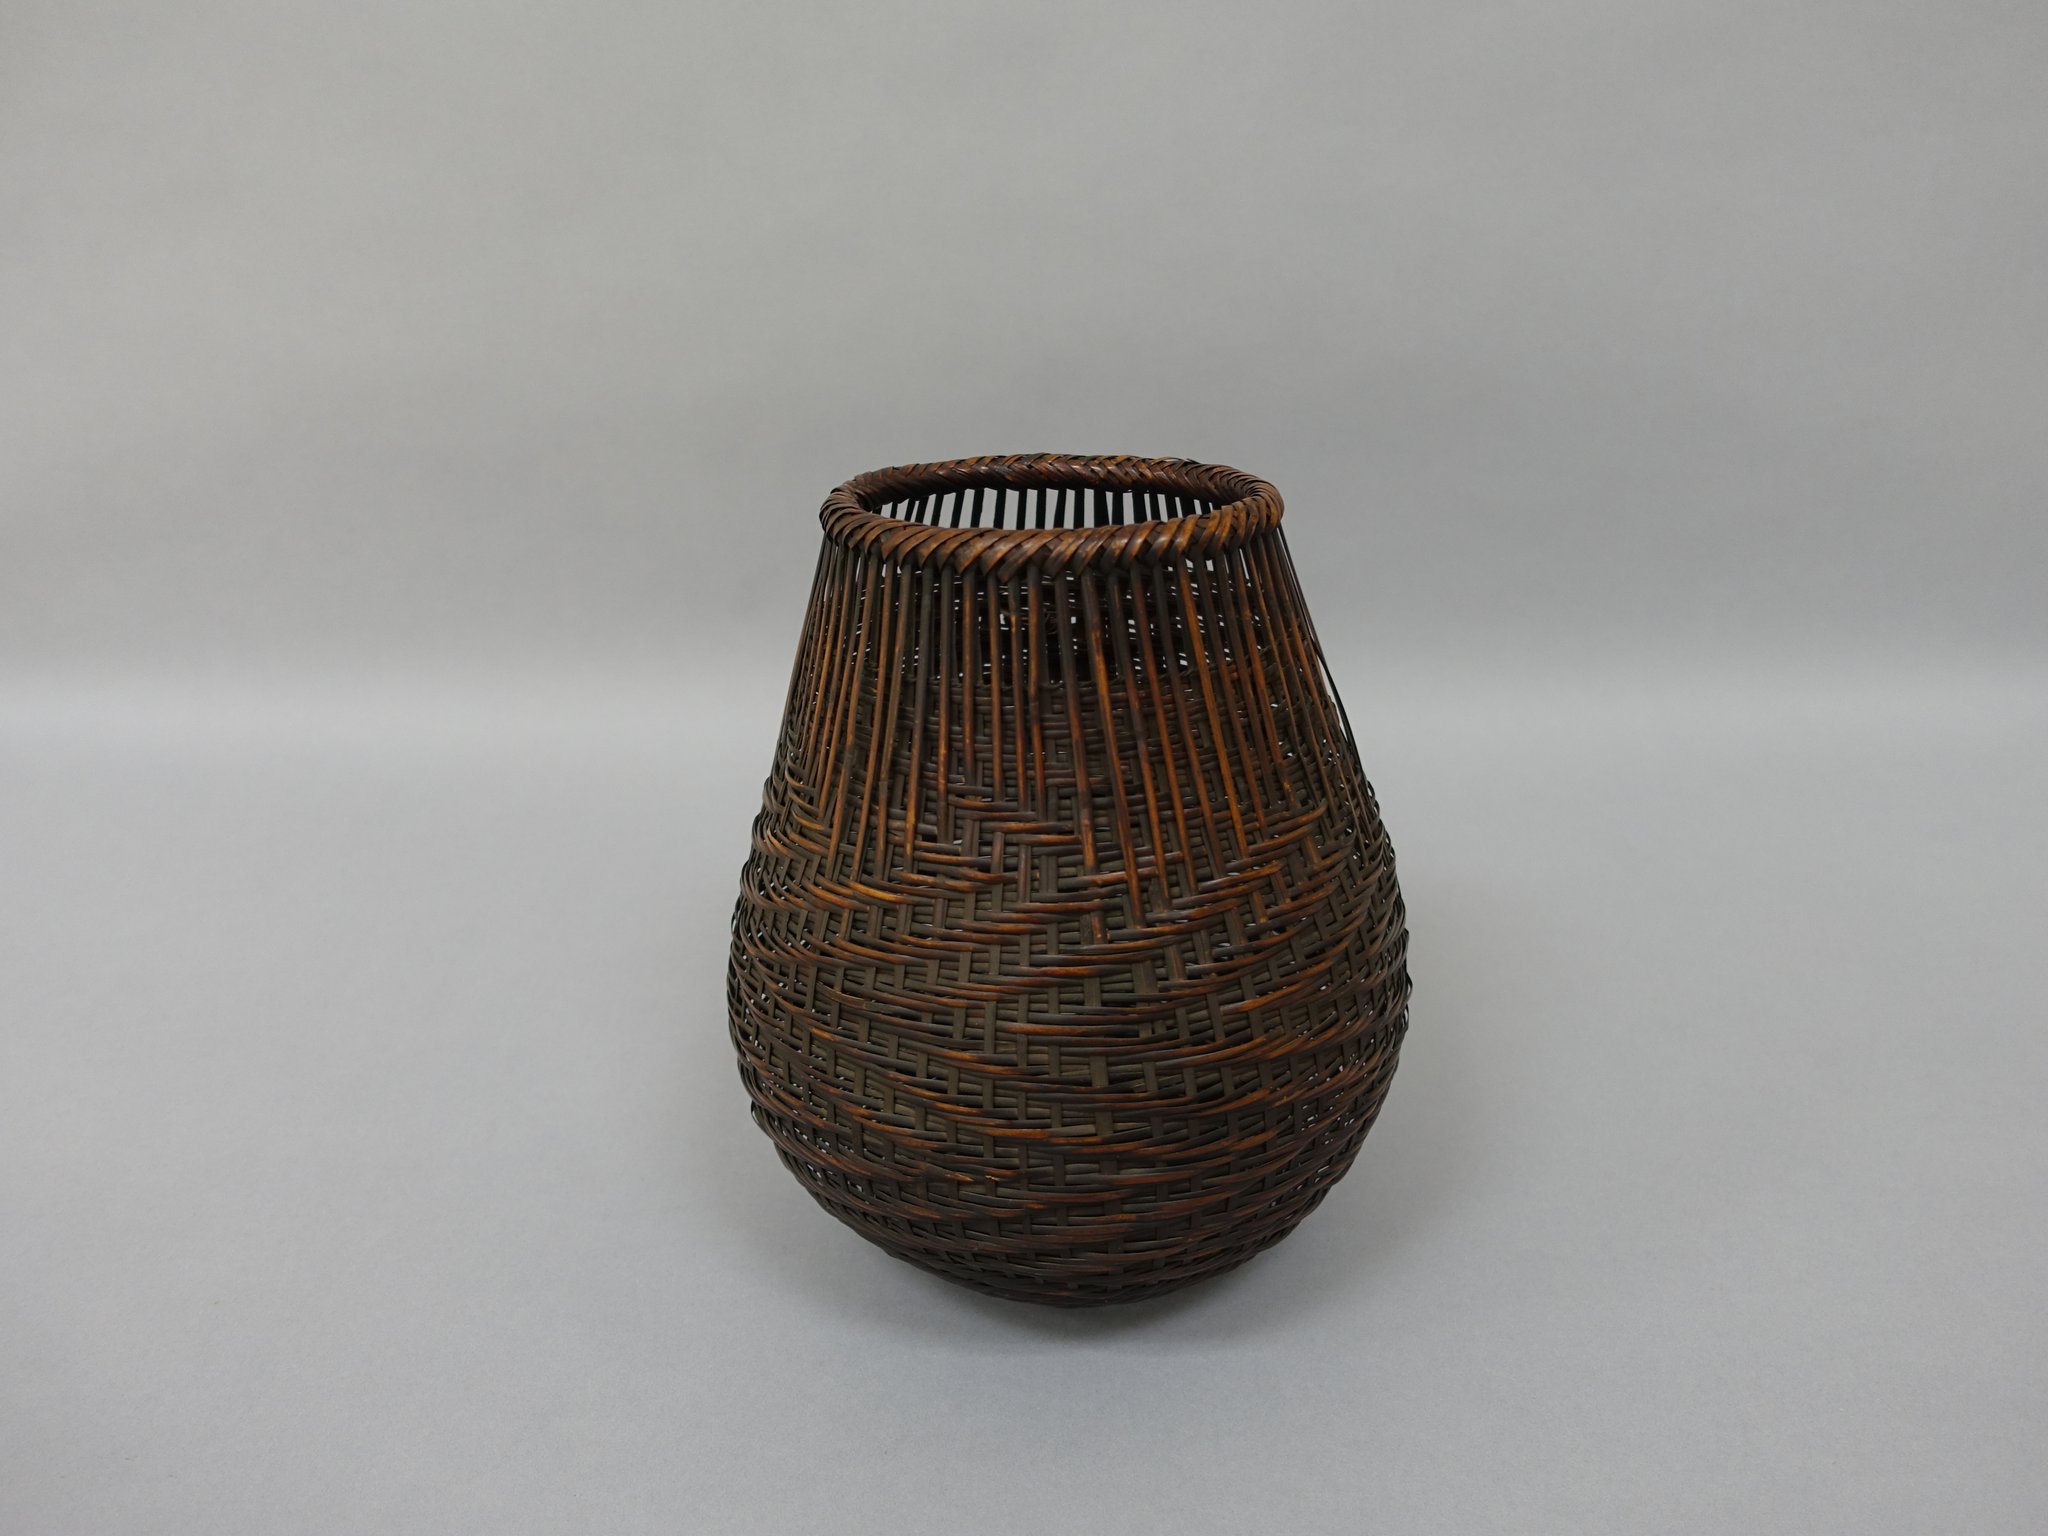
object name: basket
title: Fishing-Style Basket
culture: japanese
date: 1801-1900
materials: bamboo